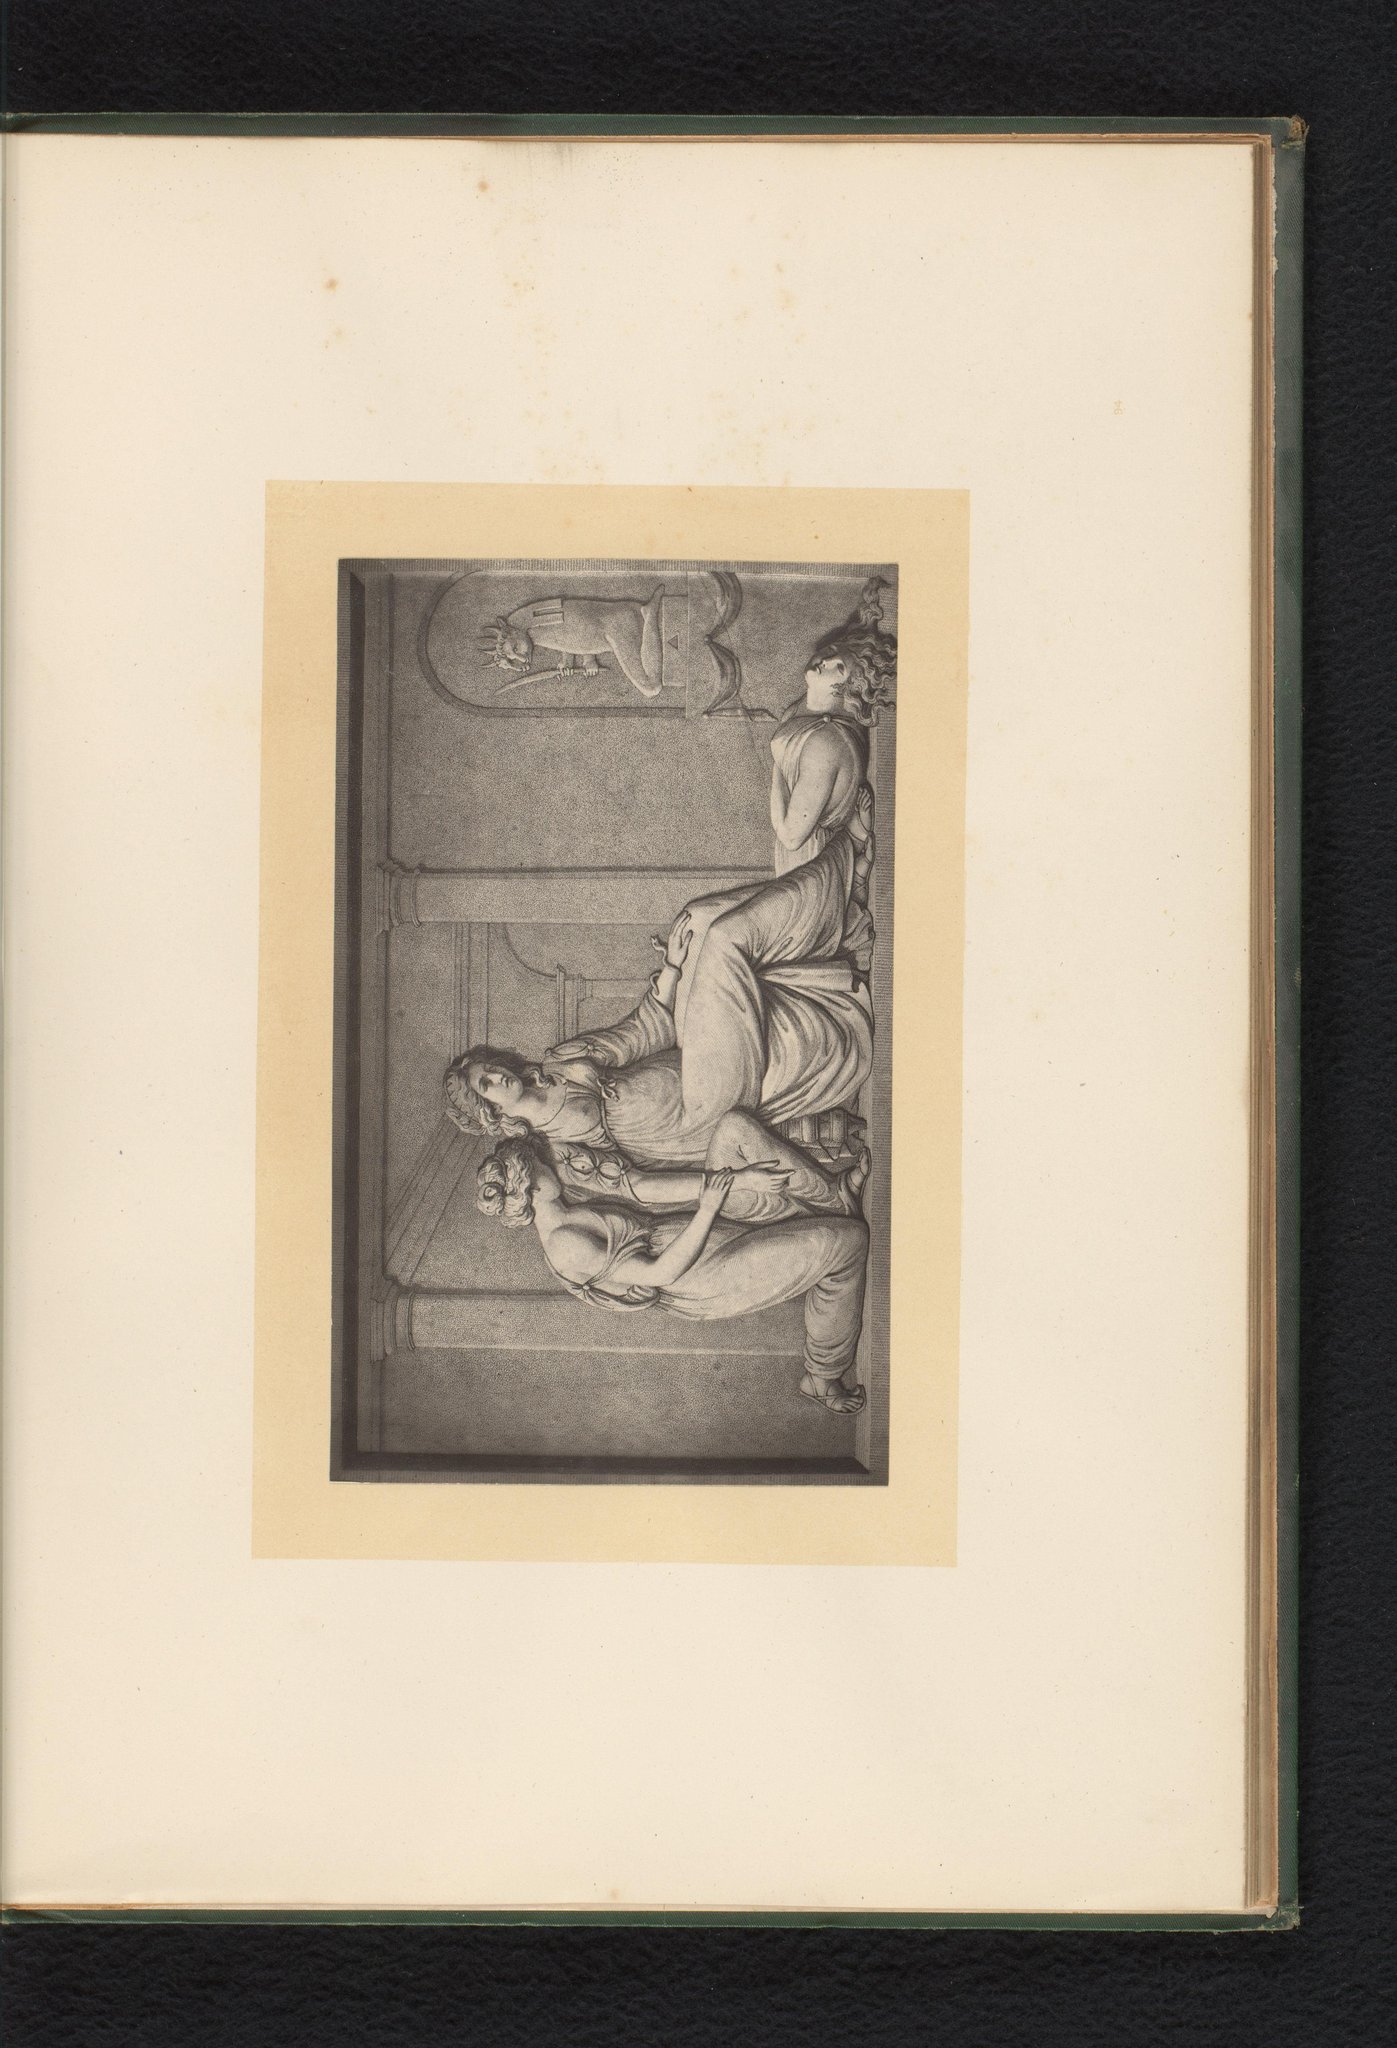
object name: reproduction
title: Reproductie van een gravure naar een reliëf van een scène uit Antony and Cleopatra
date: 1874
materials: paper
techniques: woodburytype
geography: london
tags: theatre, theatrical performance, piece of sculpture, reproduction of a piece of sculpture